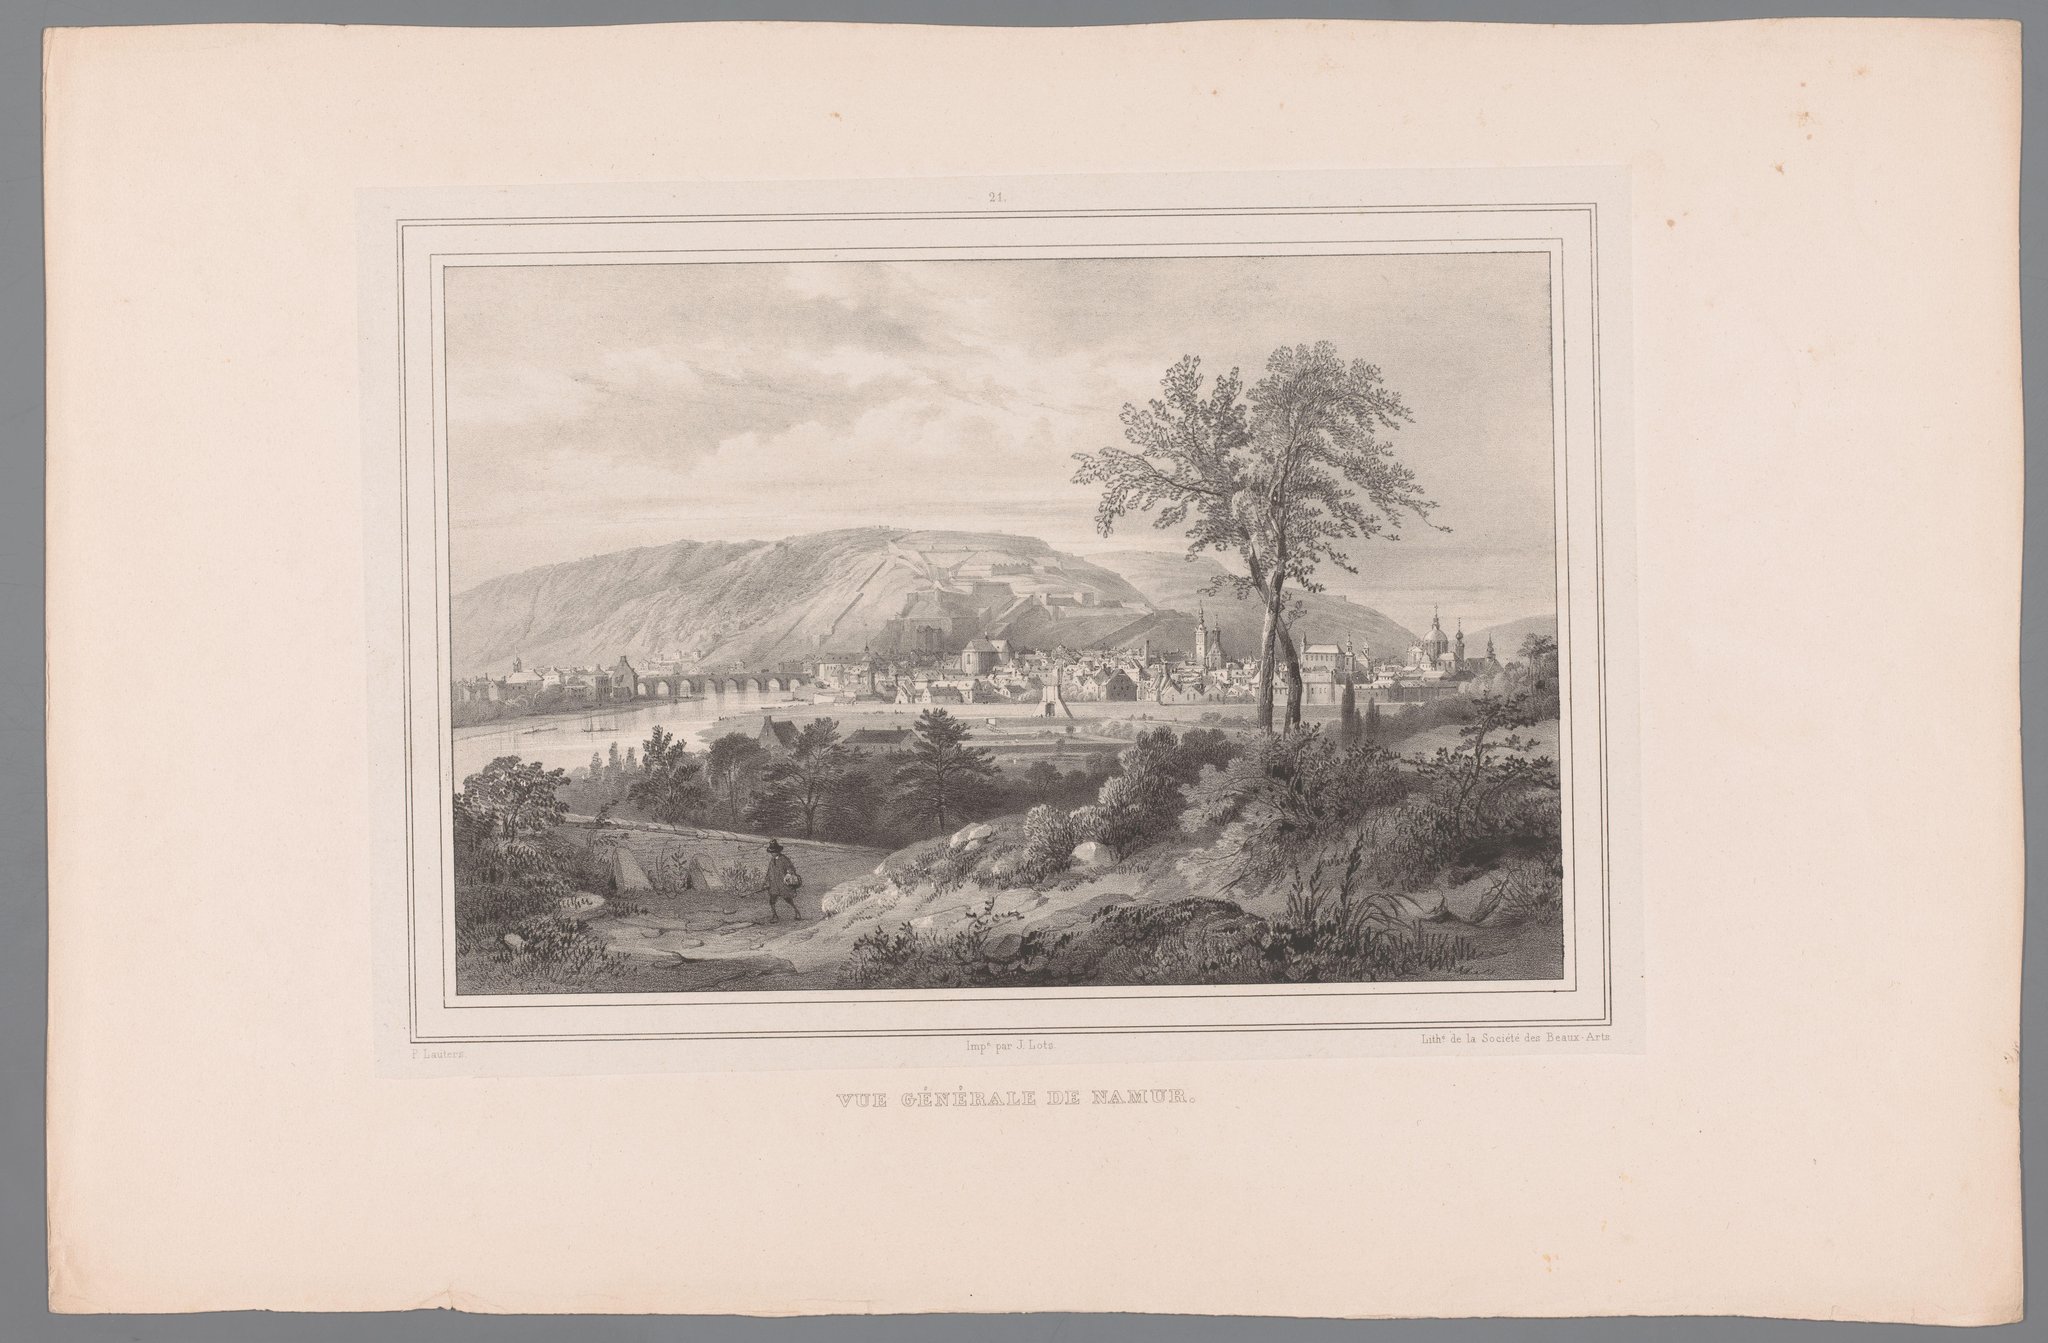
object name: print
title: Gezicht op Namen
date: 1839-1841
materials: paper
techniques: lithograph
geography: brussels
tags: prospect of city, town panorama, silhouette of city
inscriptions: collector's mark: Lugt 2228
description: Prent verschenen in: Van Hasselt, André. Voyage aux bords de la Meuse. Brussel: Société des Beaux-Arts, 1839-1841. Deze publicatie bevat 36 litho's.